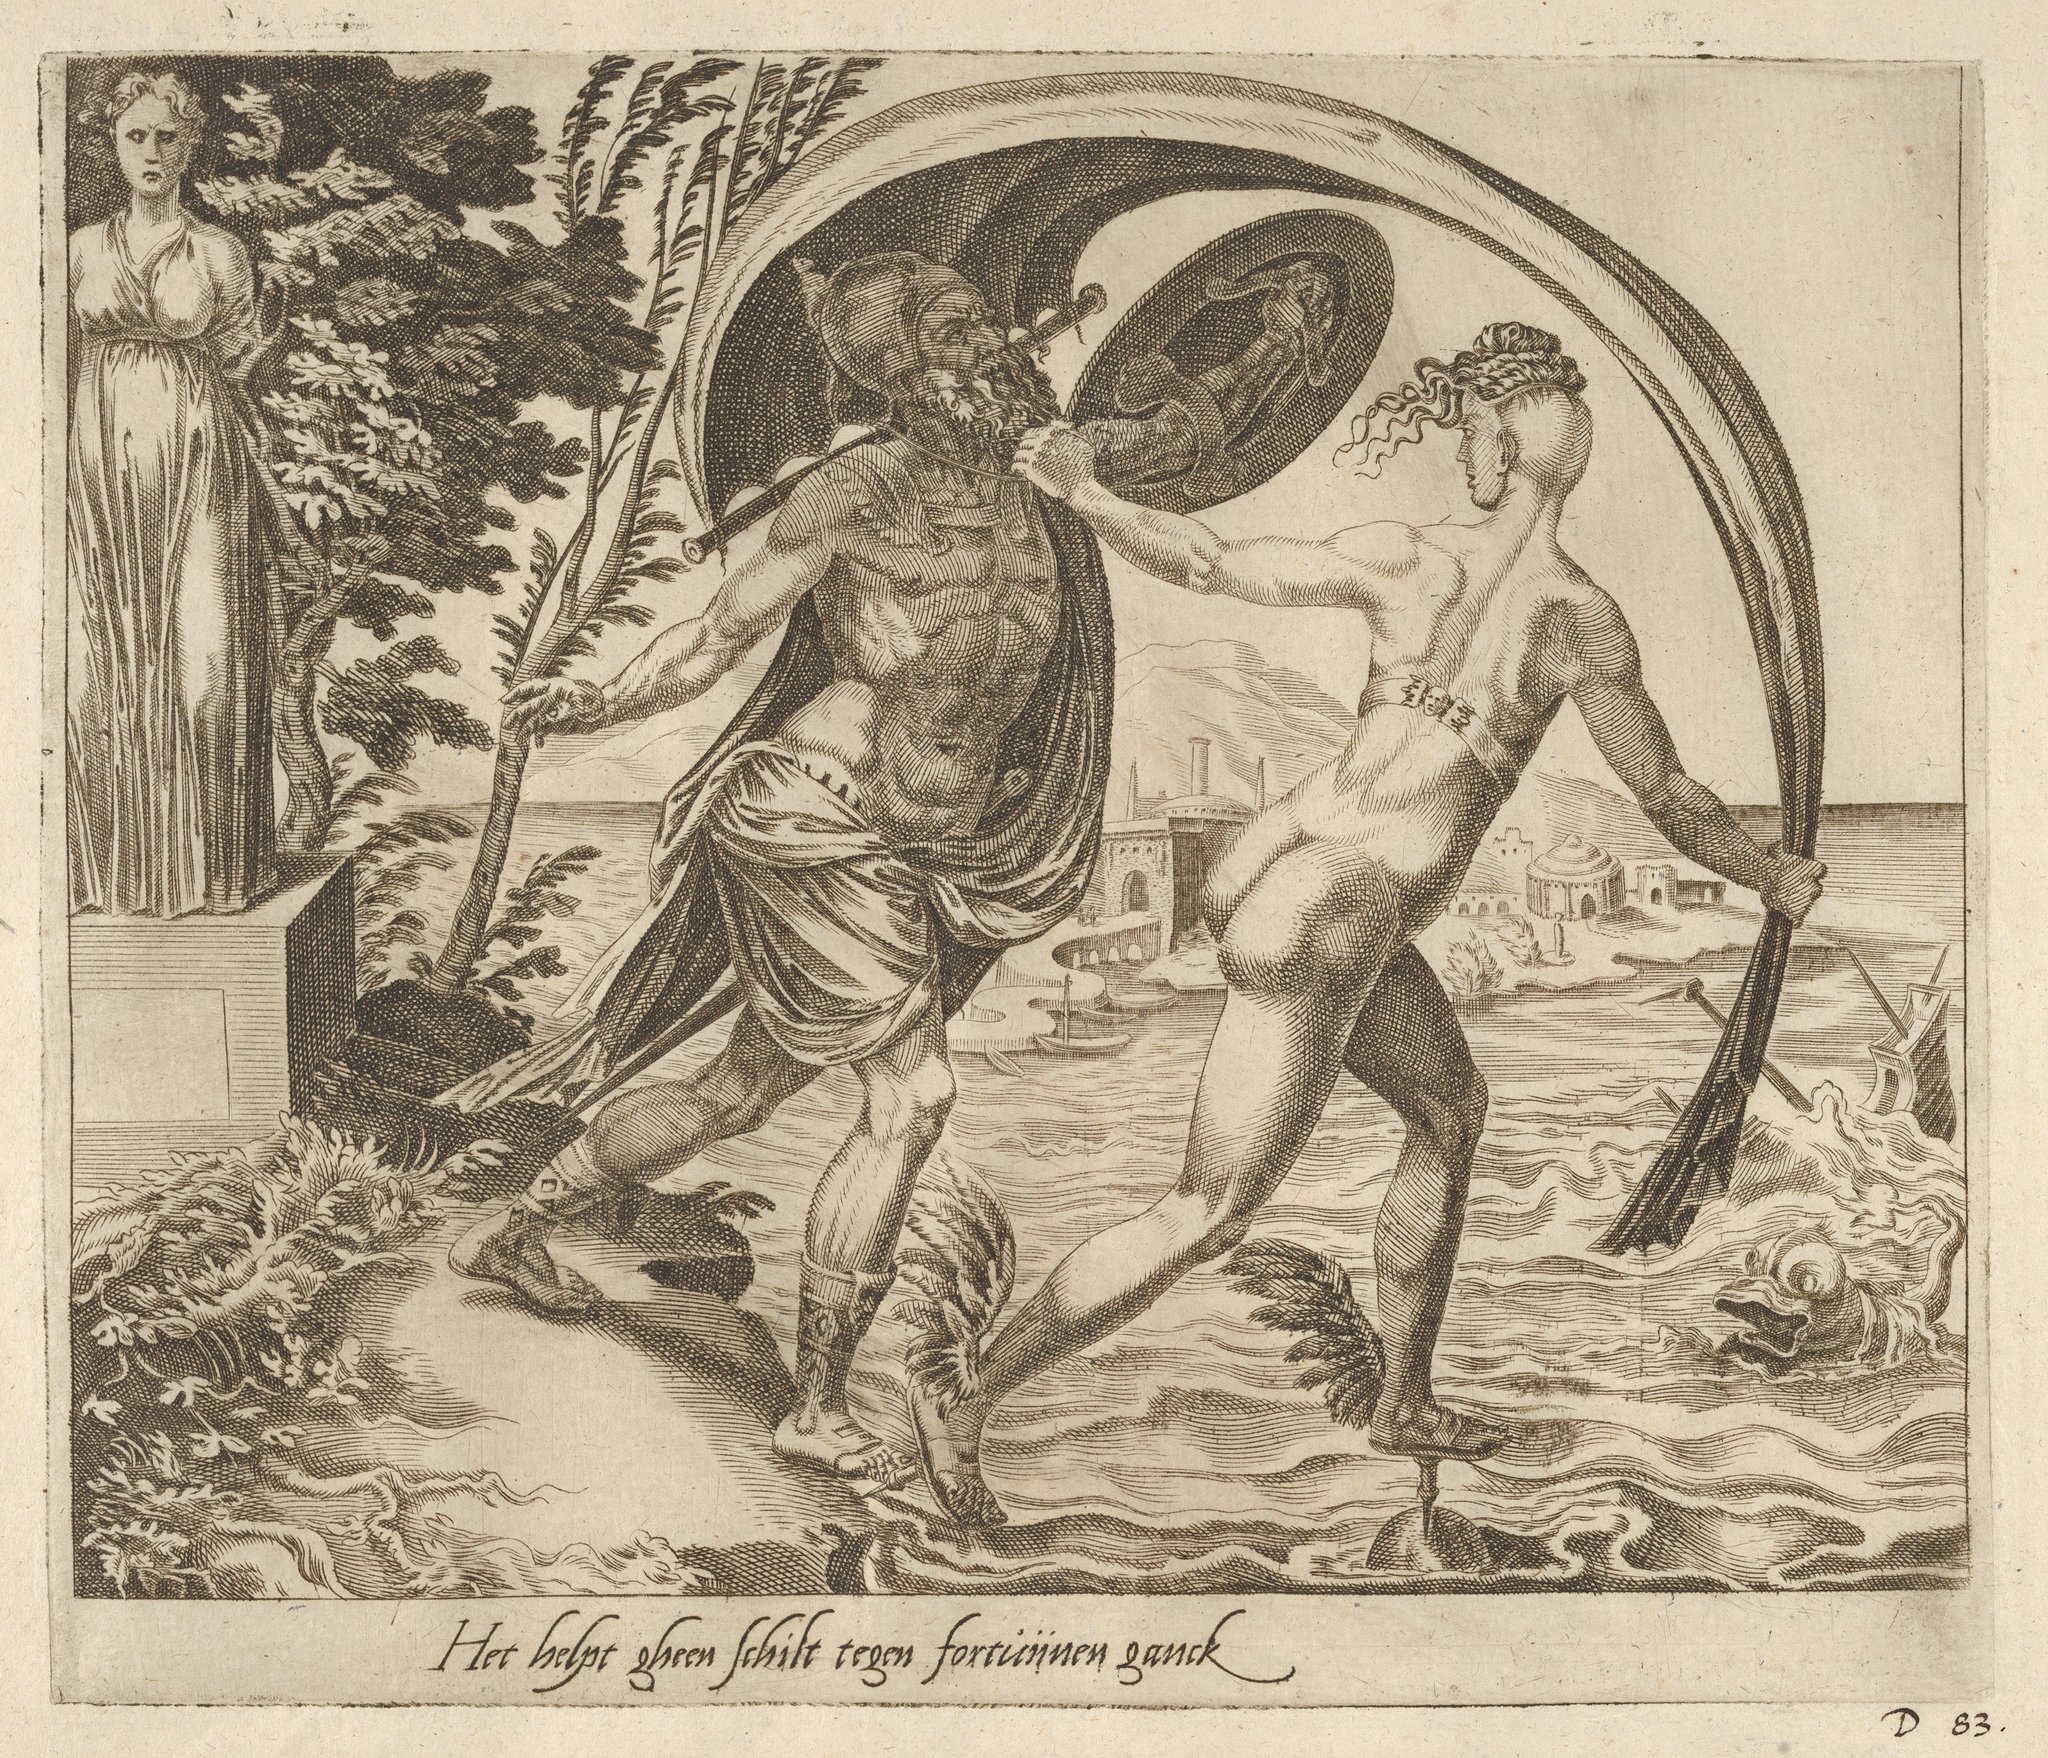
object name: print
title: A Shield is of no Use when Fortune Turns Her Back from Six Sayings about Fortune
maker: dirck volckertsz coornhert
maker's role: artist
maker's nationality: netherlandish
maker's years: 1519-1590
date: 1560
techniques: engraving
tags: men,female nudes